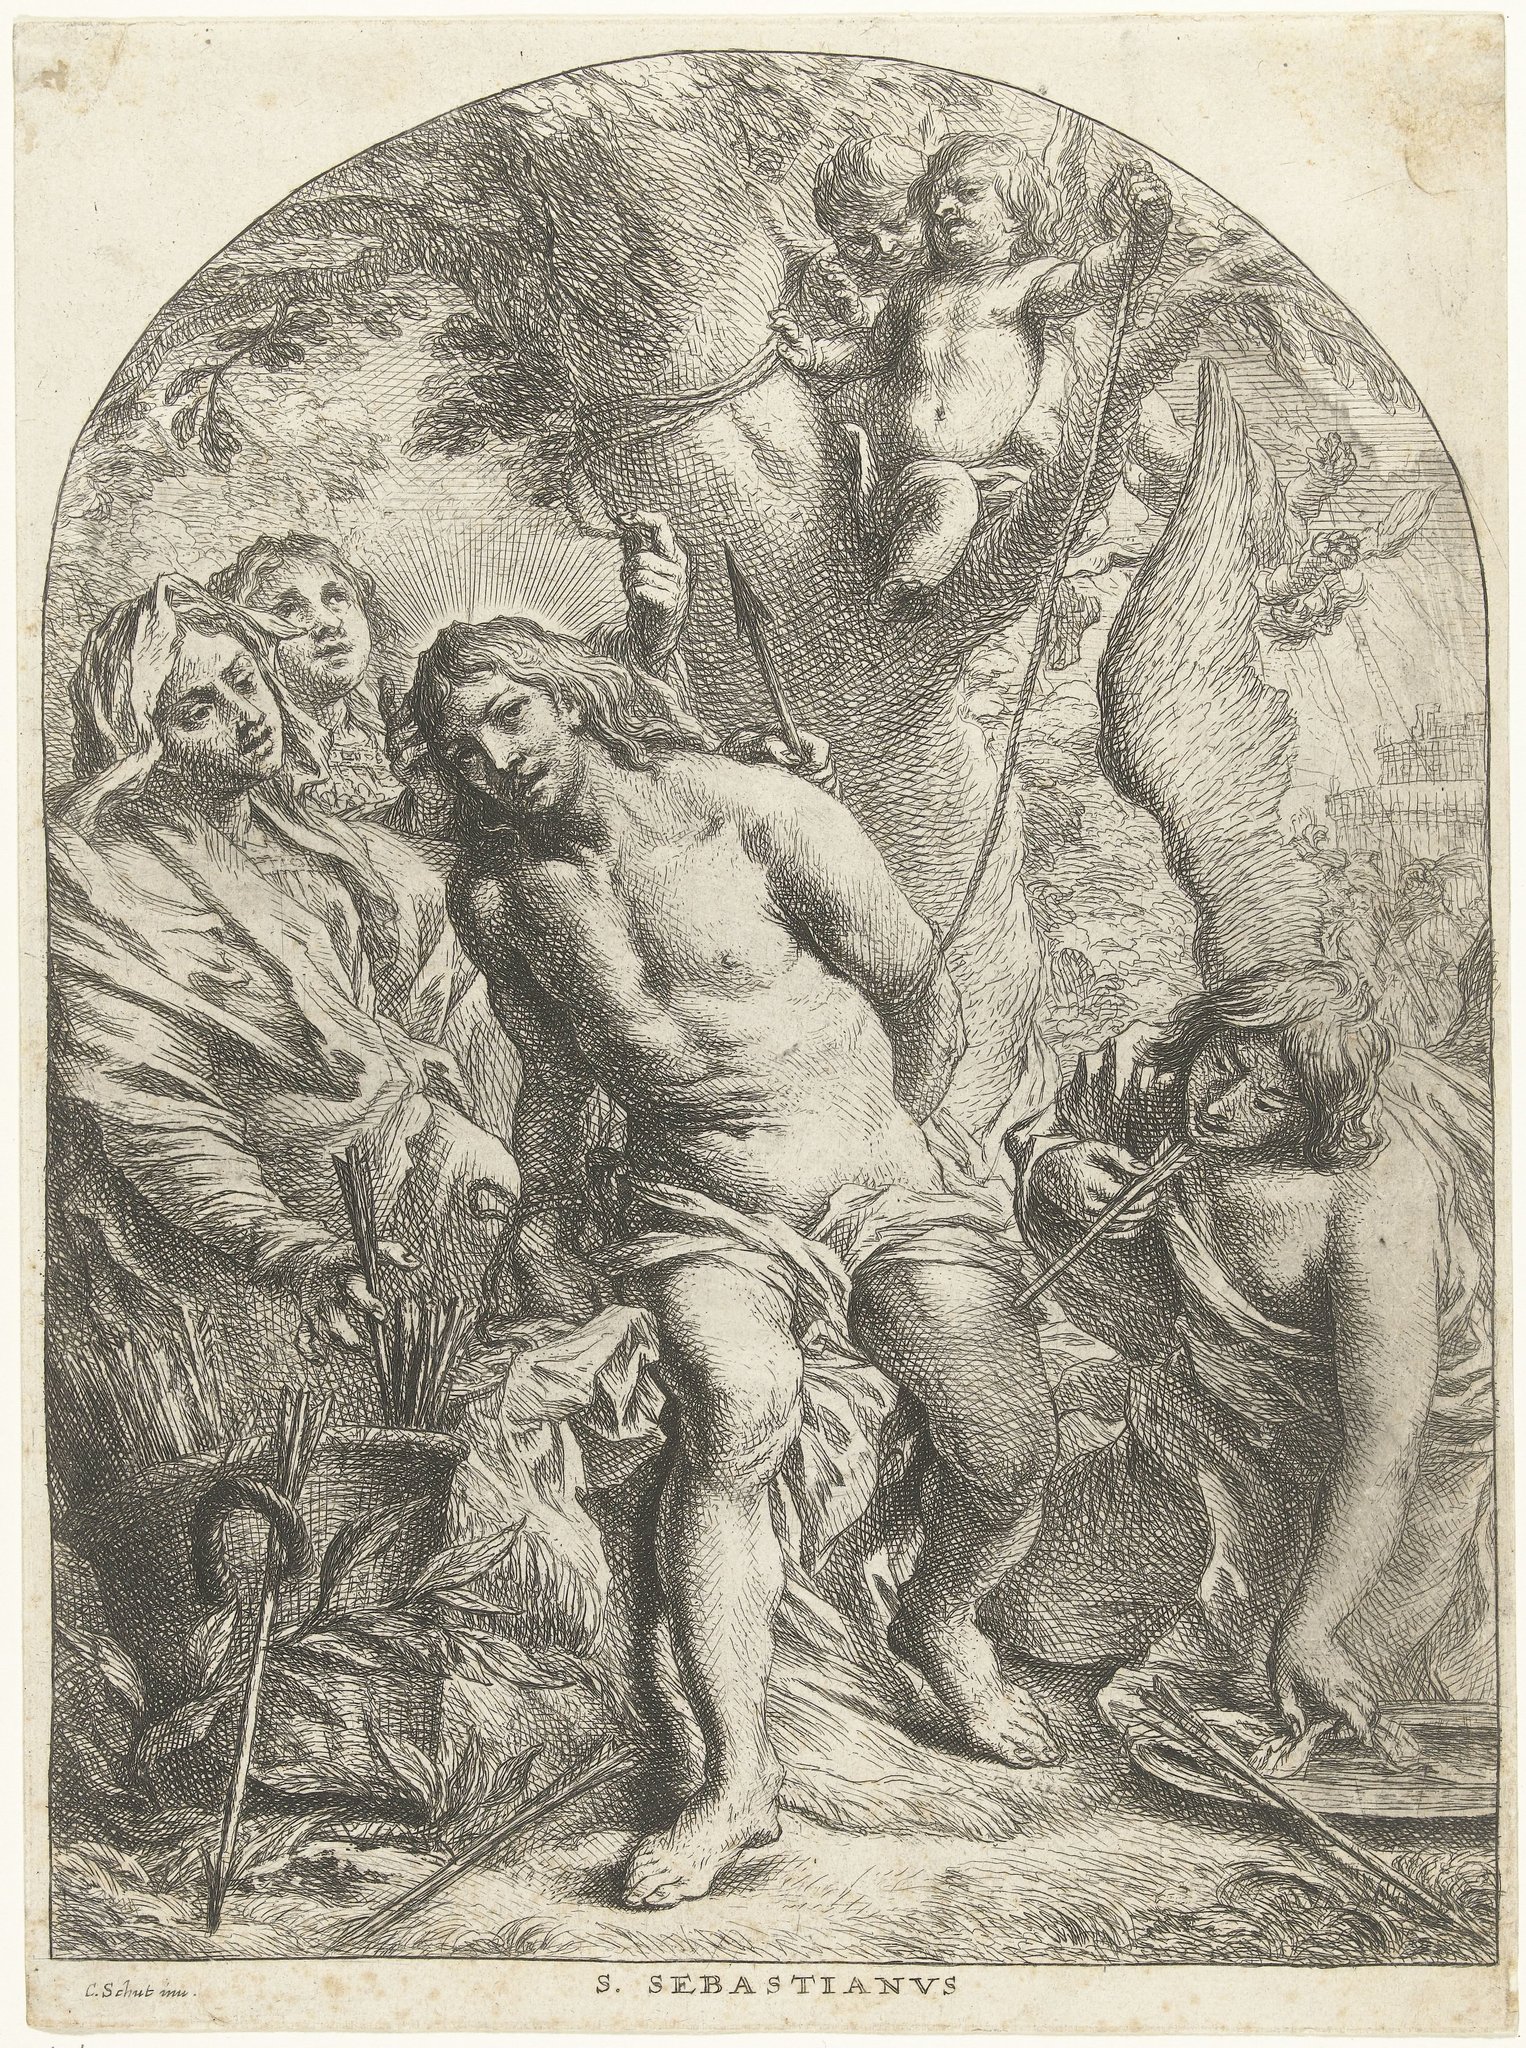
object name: print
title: S. Sebastianvs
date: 1626-1680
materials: paper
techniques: etching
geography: antwerp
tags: the martyr sebastian; possible attributes: arrow(s), bow, tree-trunk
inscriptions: collector's mark: Lugt 2228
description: De heilige Sebastiaan is met zijn armen vastgebonden aan een boom. Een pijl doorboort zijn been. Naast hem twee personen en een mand met pijlen, aan de andere kant een engel die zijn wonden verzorgt.